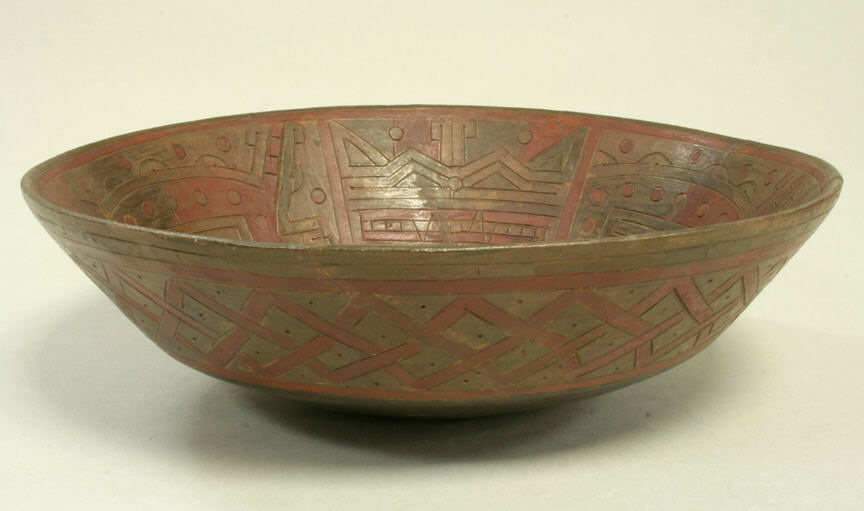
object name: bowl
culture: paracas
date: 700-201 BCE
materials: ceramic, pigment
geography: peru